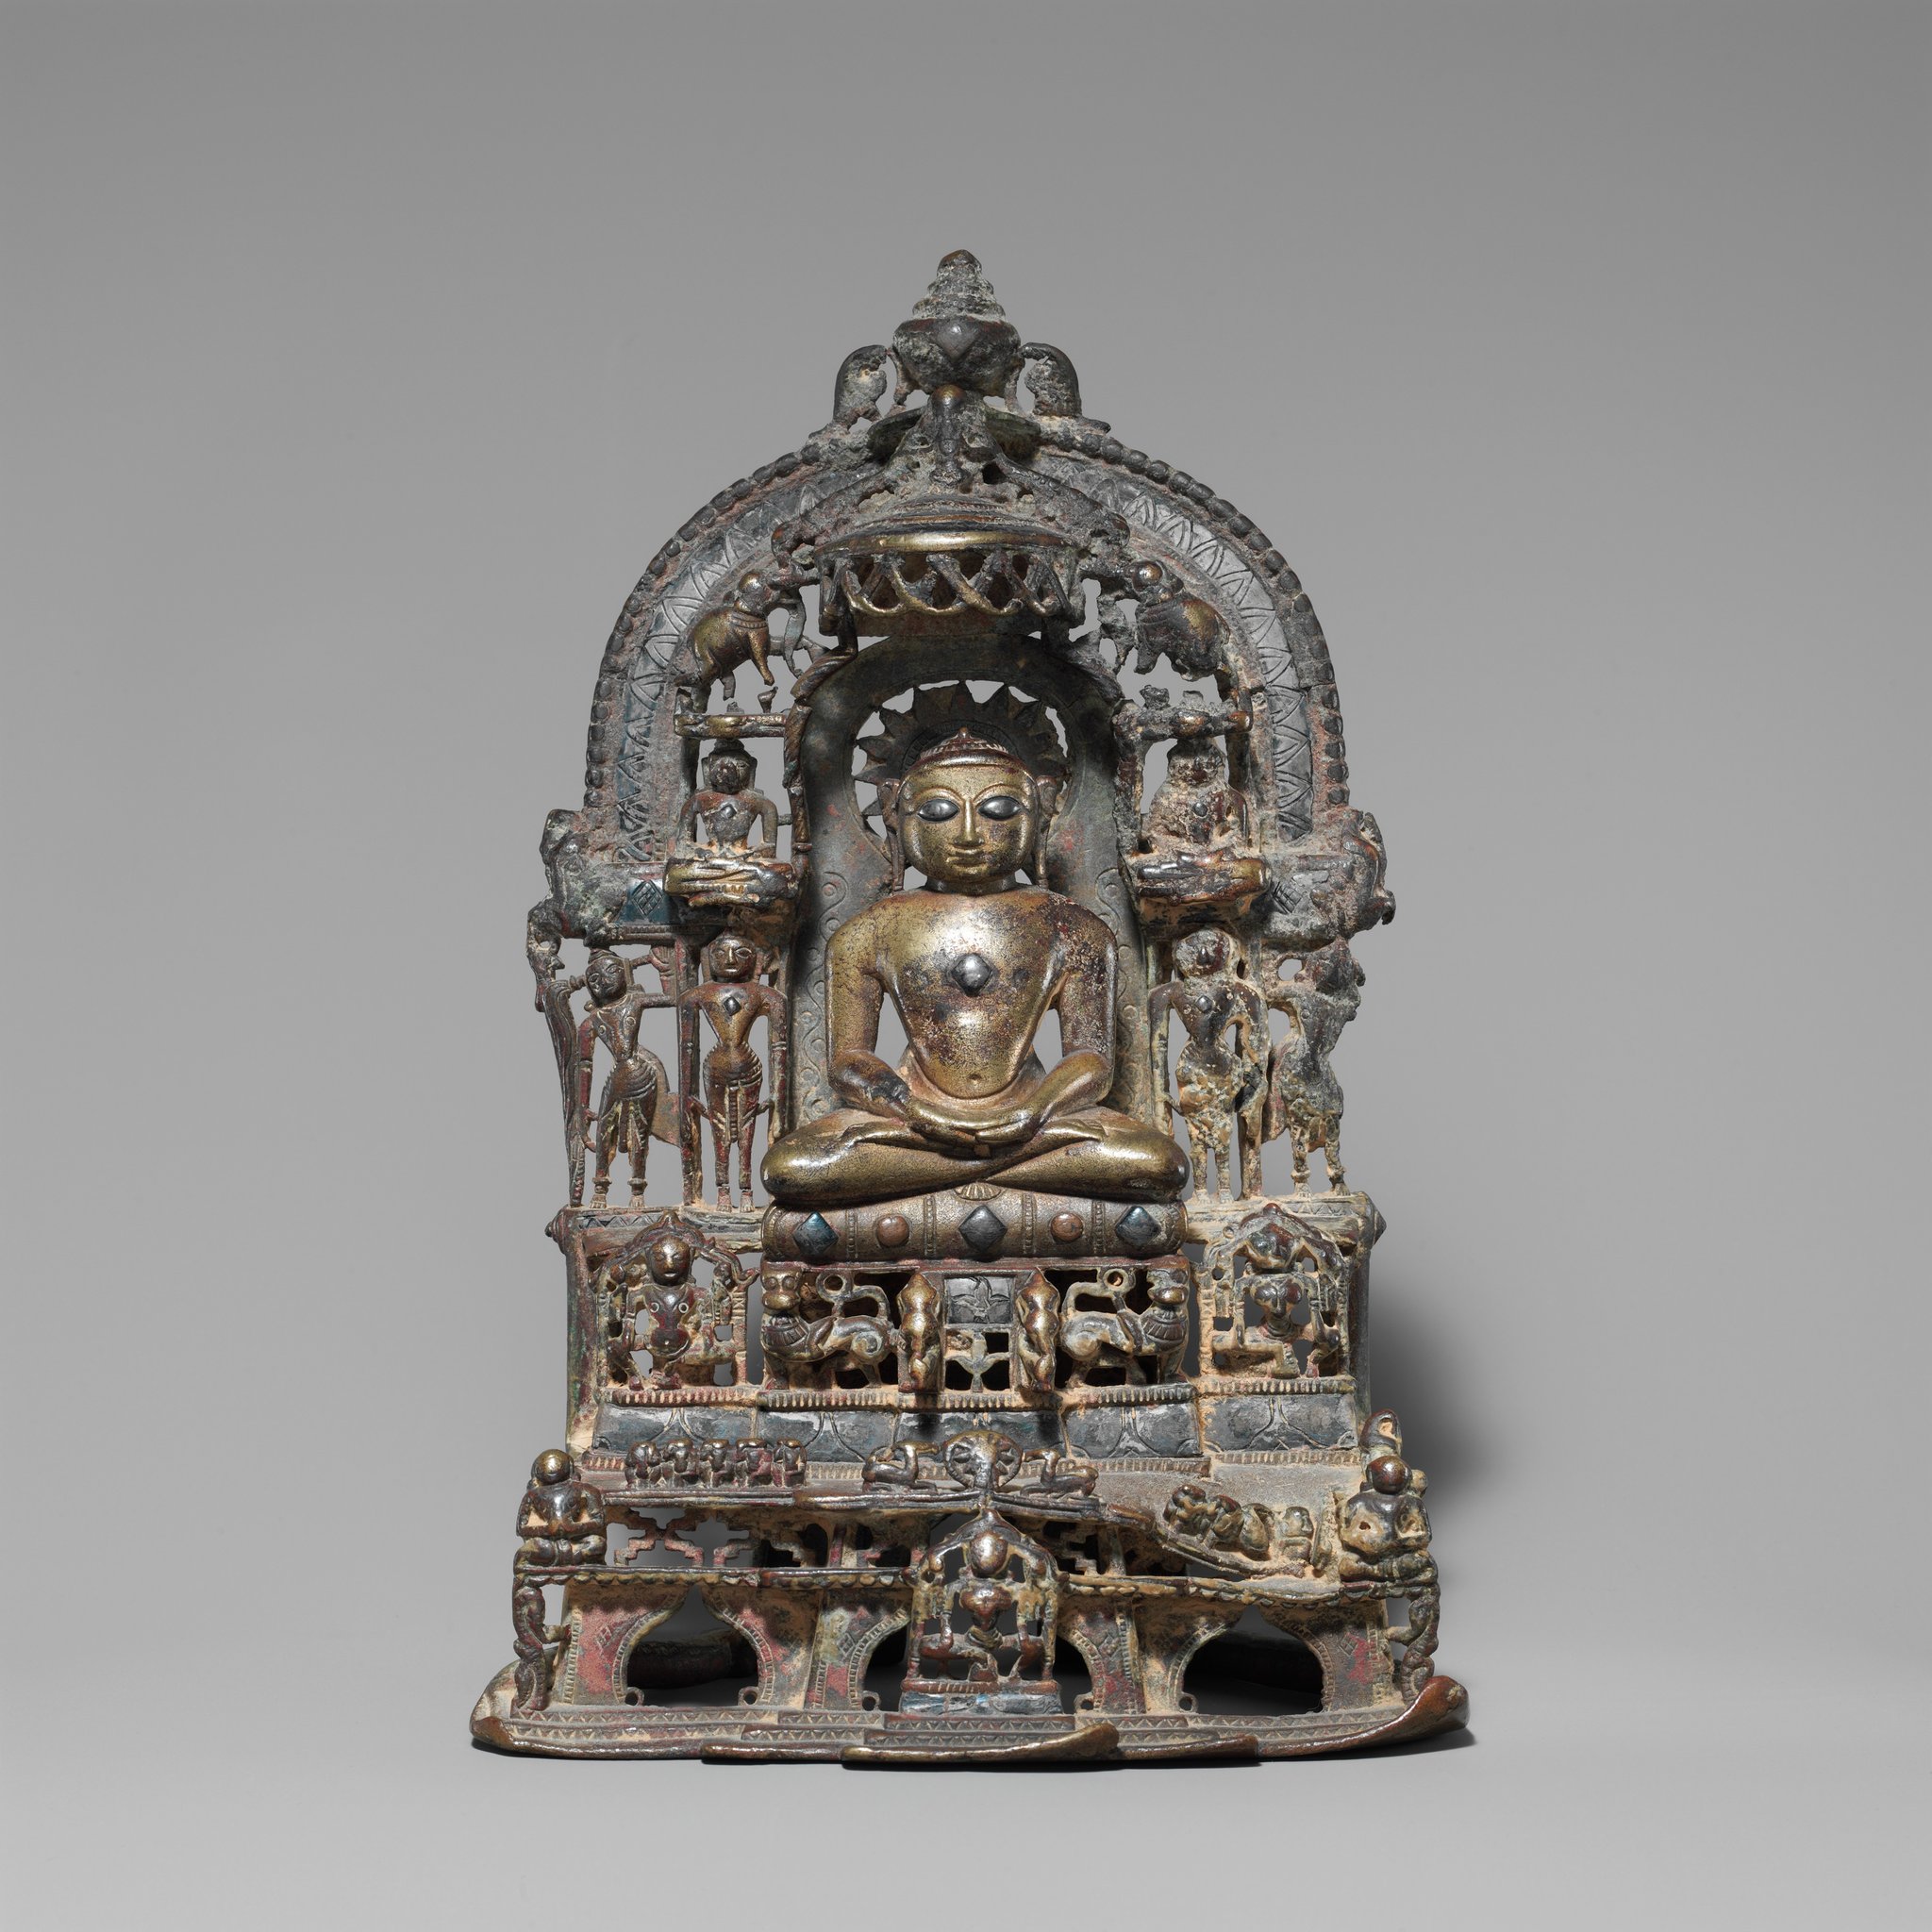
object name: figure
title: Seated Jain Tirthankara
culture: indian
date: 1401-1500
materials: bronze